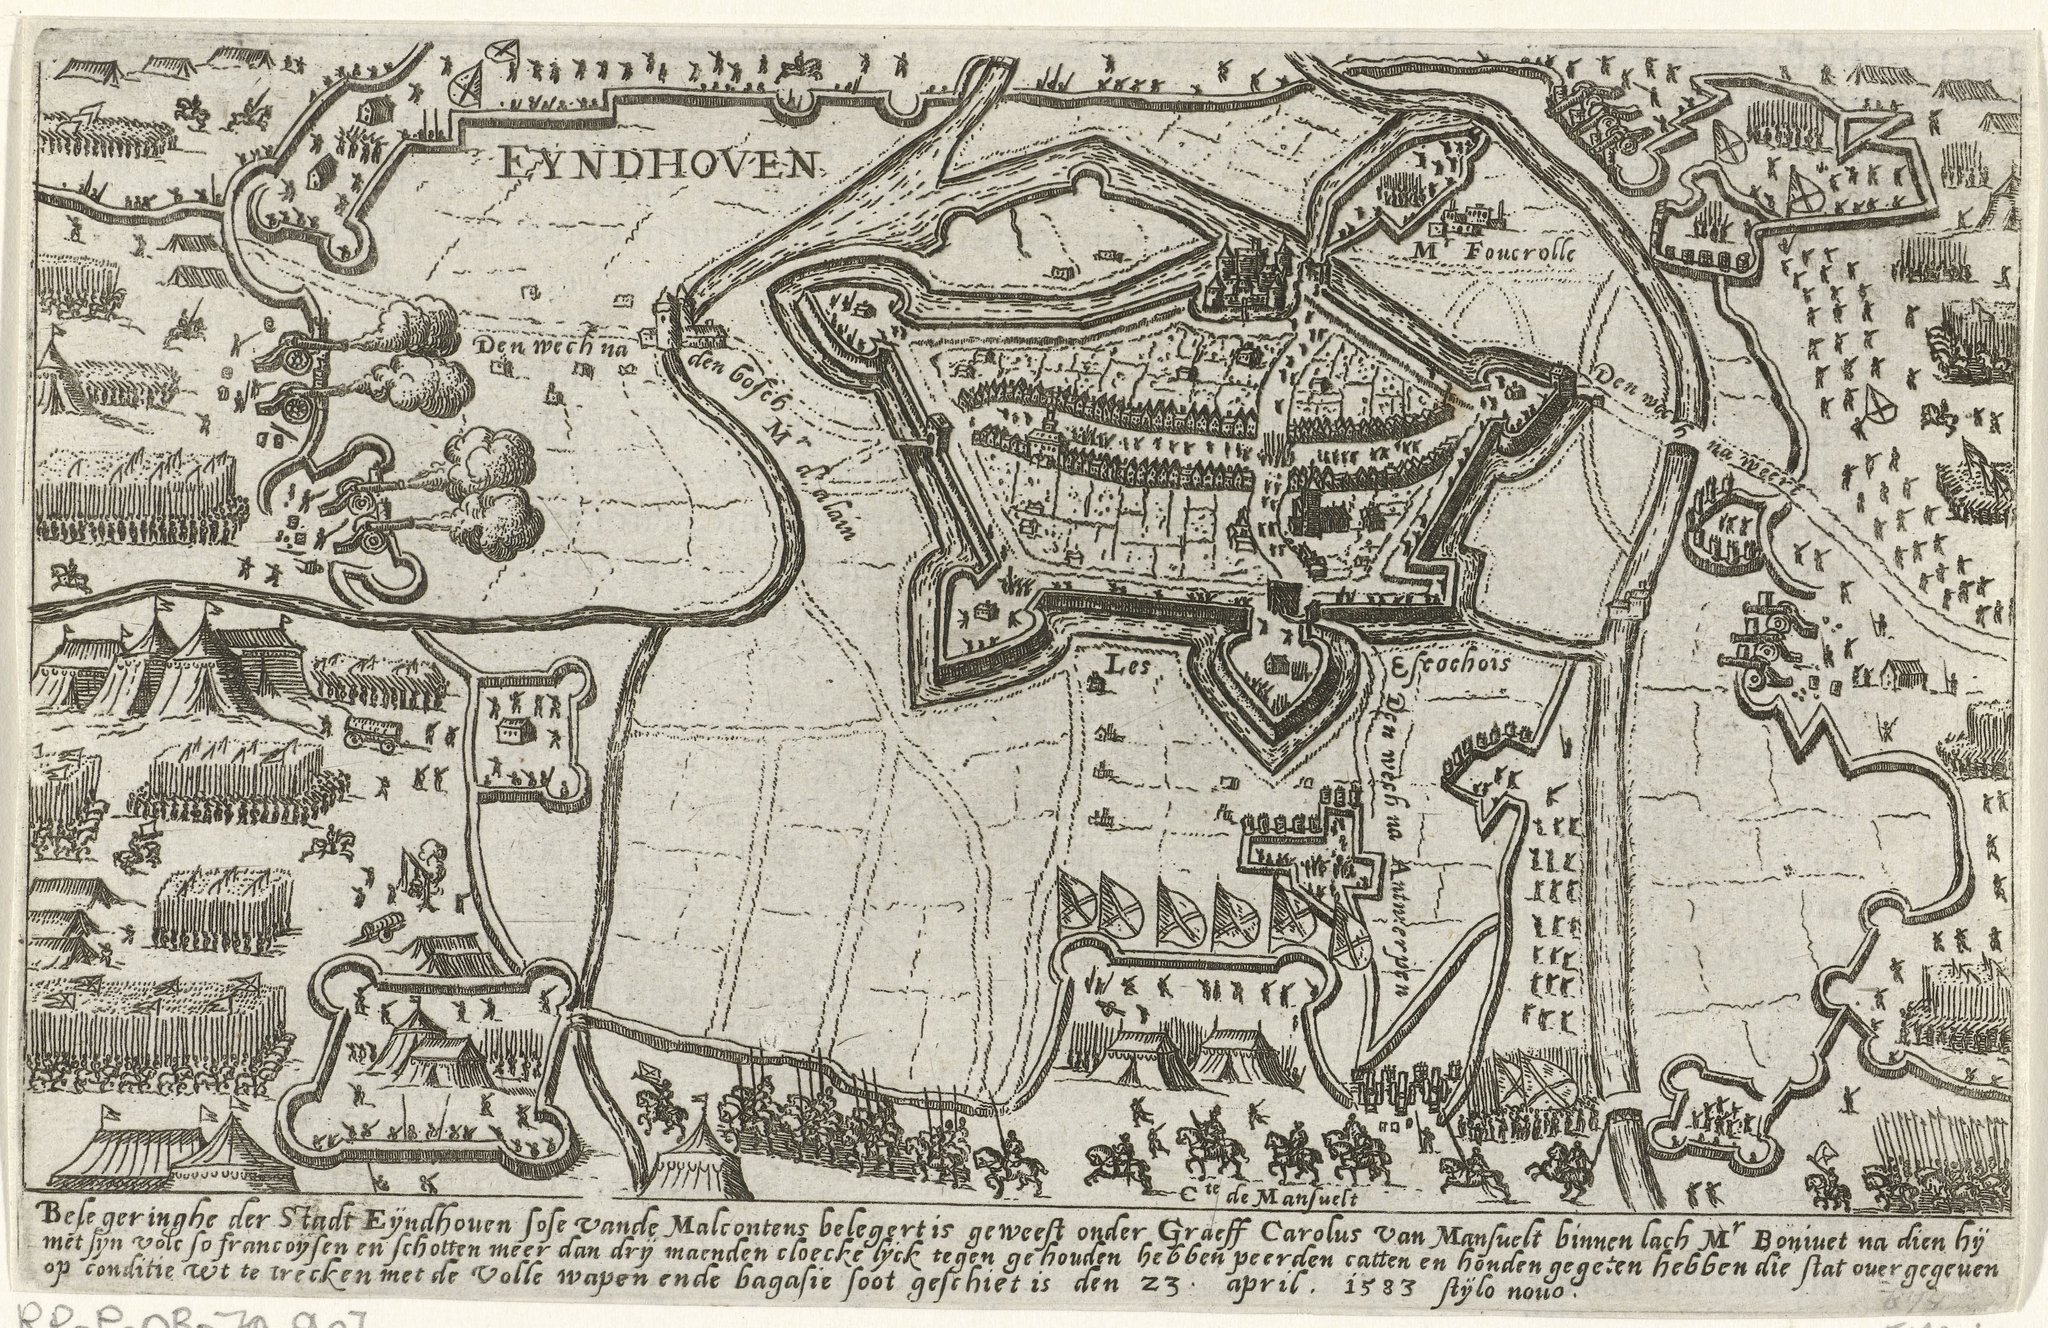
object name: print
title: Beleg van Eindhoven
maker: Anonymous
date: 1613-1615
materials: paper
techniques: etching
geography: low countries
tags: siege, position war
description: Eindhoven belegerd en ingenomen door Karel, graaf van Mansveld, 23 april 1583. De troepen onder Bonnivet verdedigen de stad. Met onderschrift van 3 regels in het Nederlands. Ongenummerd. Bedrukt op achterzijde met tekst in het Latijn.